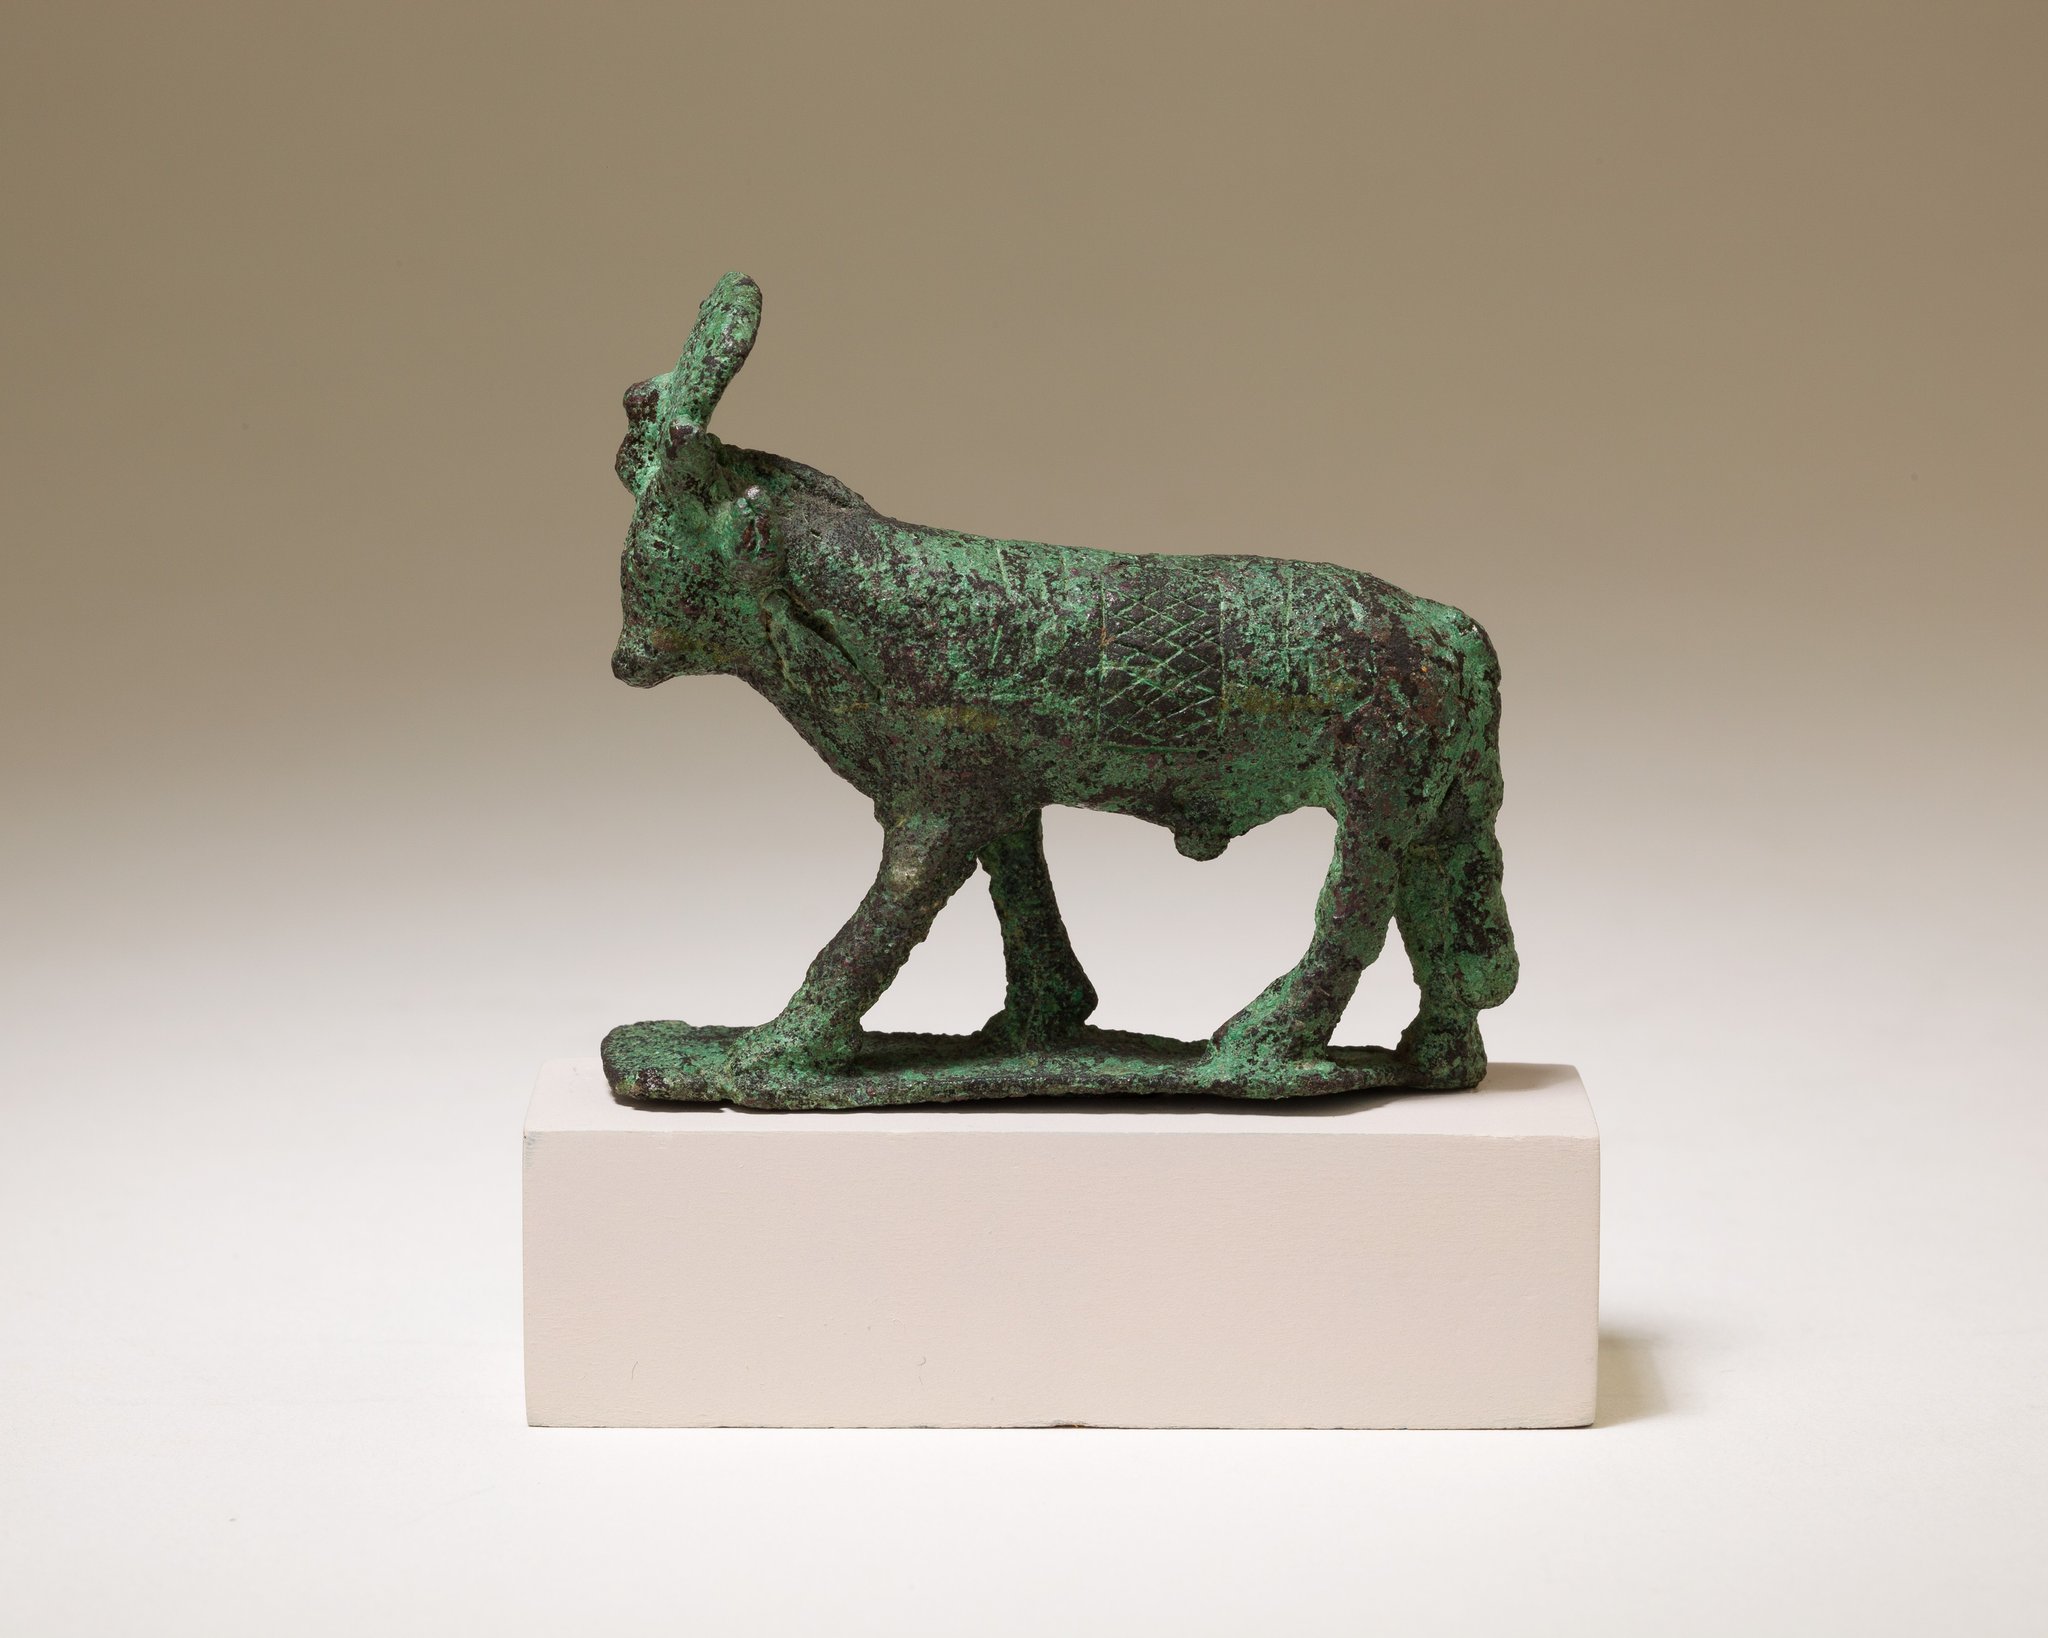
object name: figurine, apis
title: Apis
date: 664-630 BCE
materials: metal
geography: egypt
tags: animals